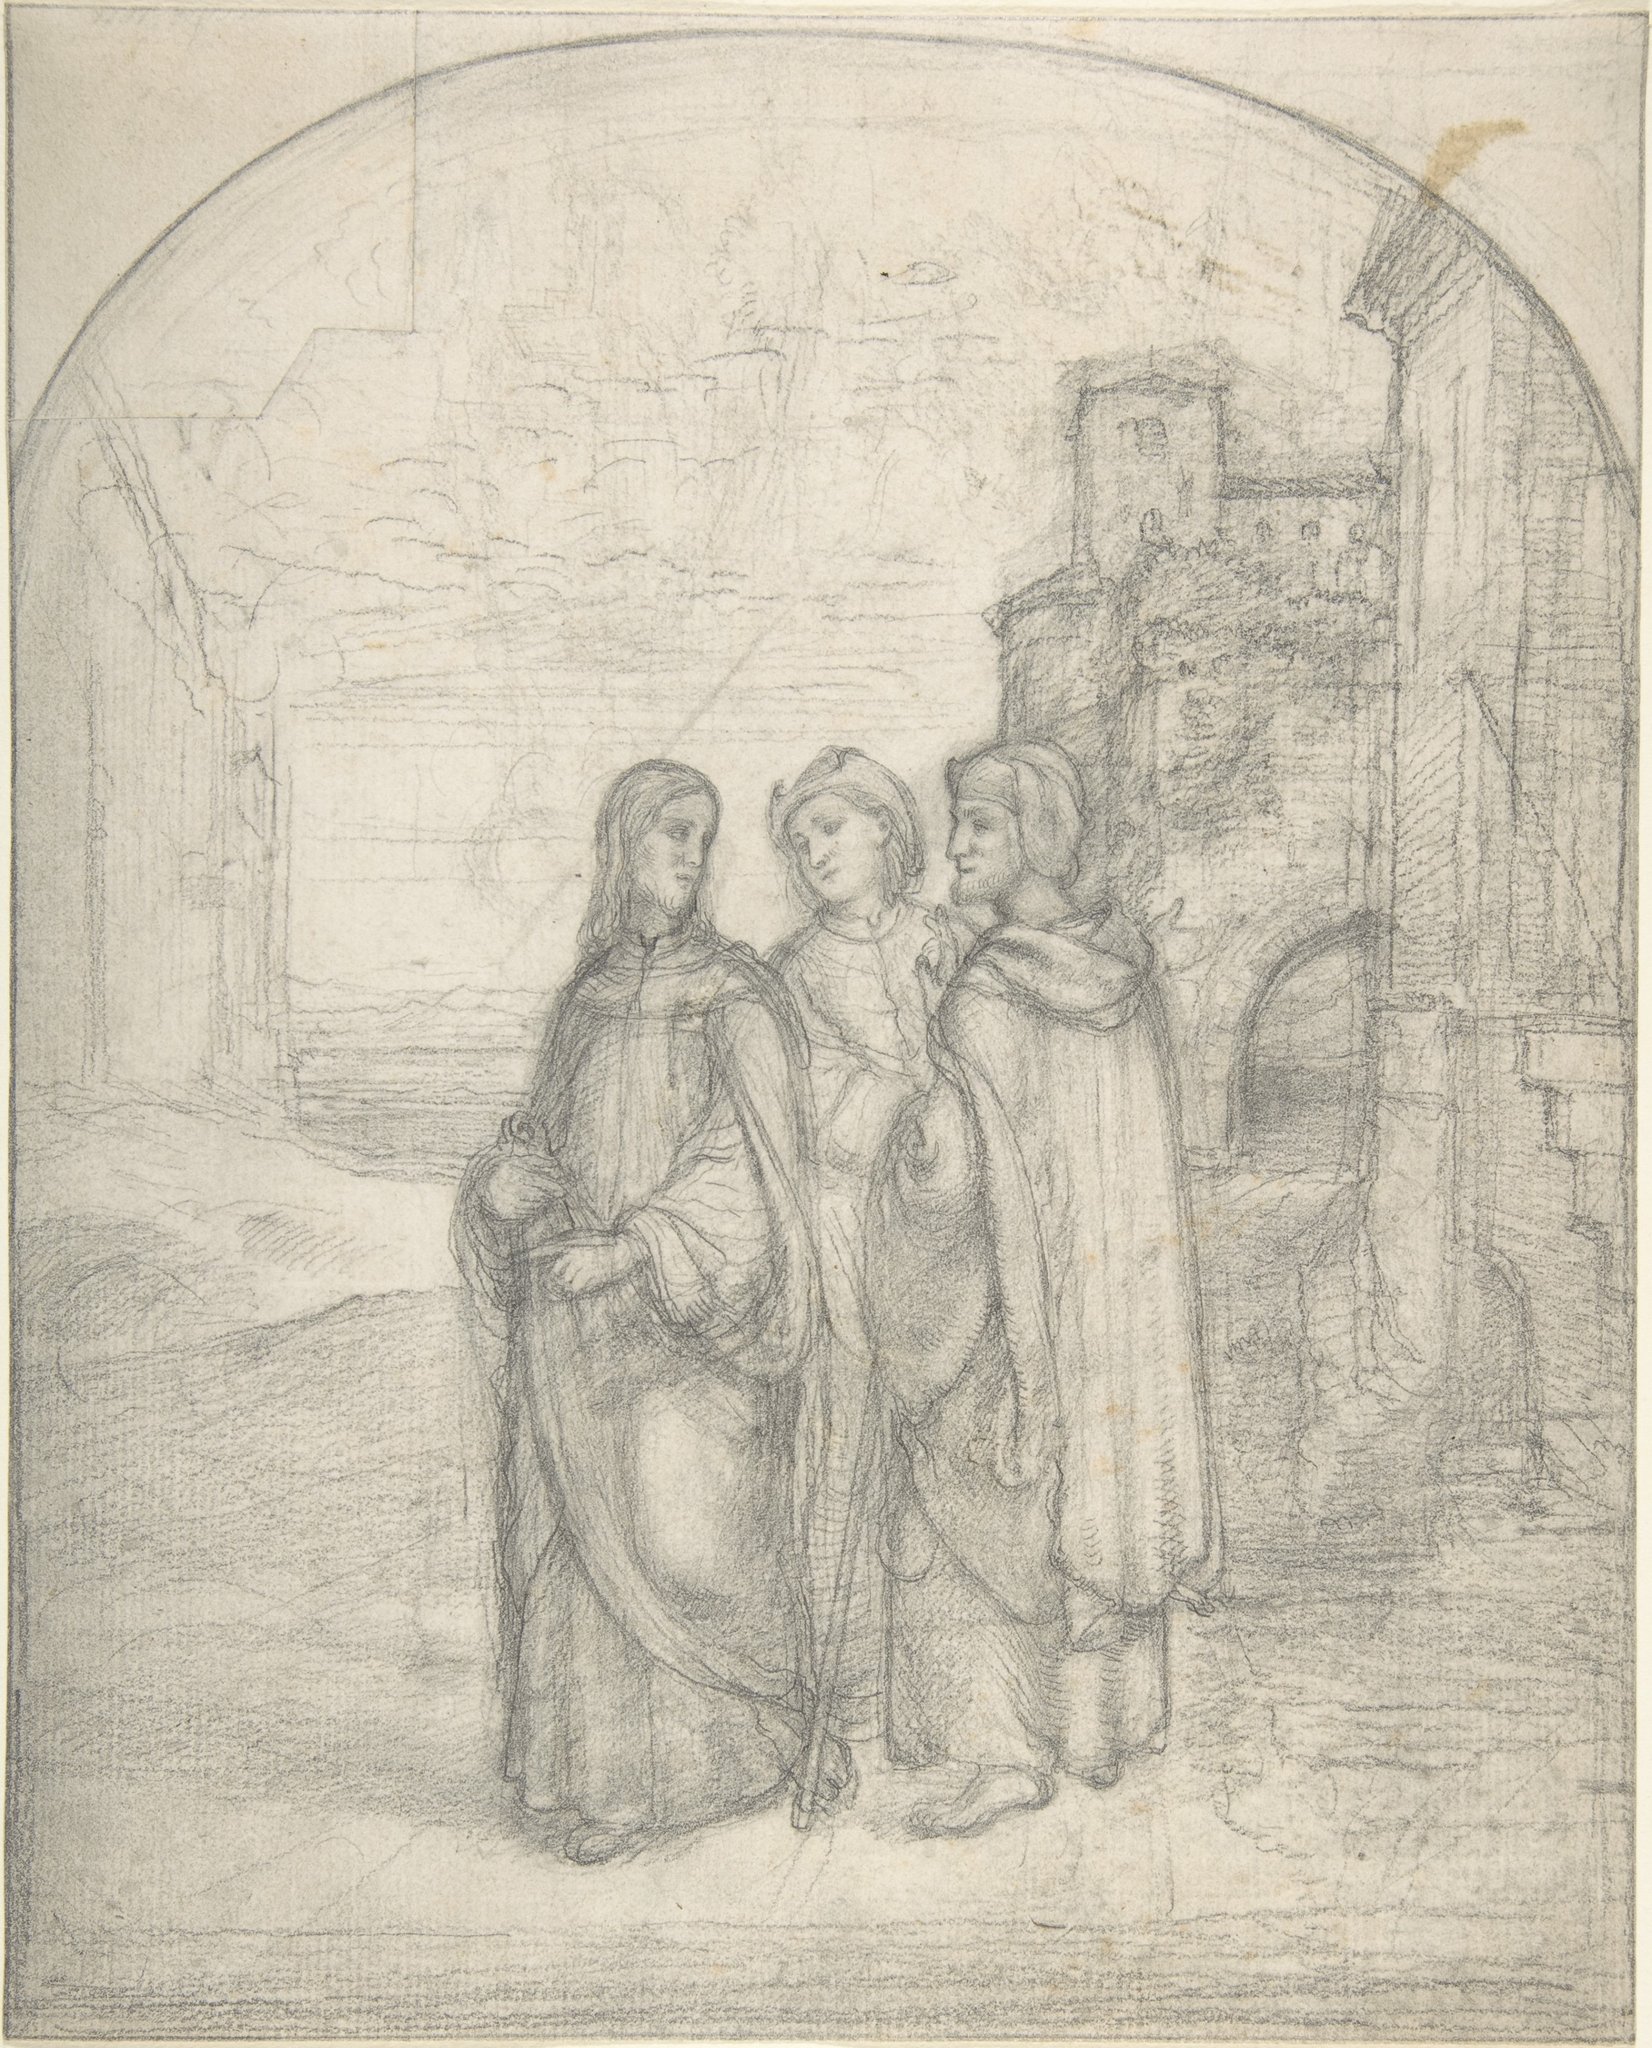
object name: drawing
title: Christ and the Pilgrims of Emmaus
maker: (johann heinrich) ferdinand olivier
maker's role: artist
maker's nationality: german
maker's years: 1785-1841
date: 1827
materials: graphite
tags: human figures,buildings,christ